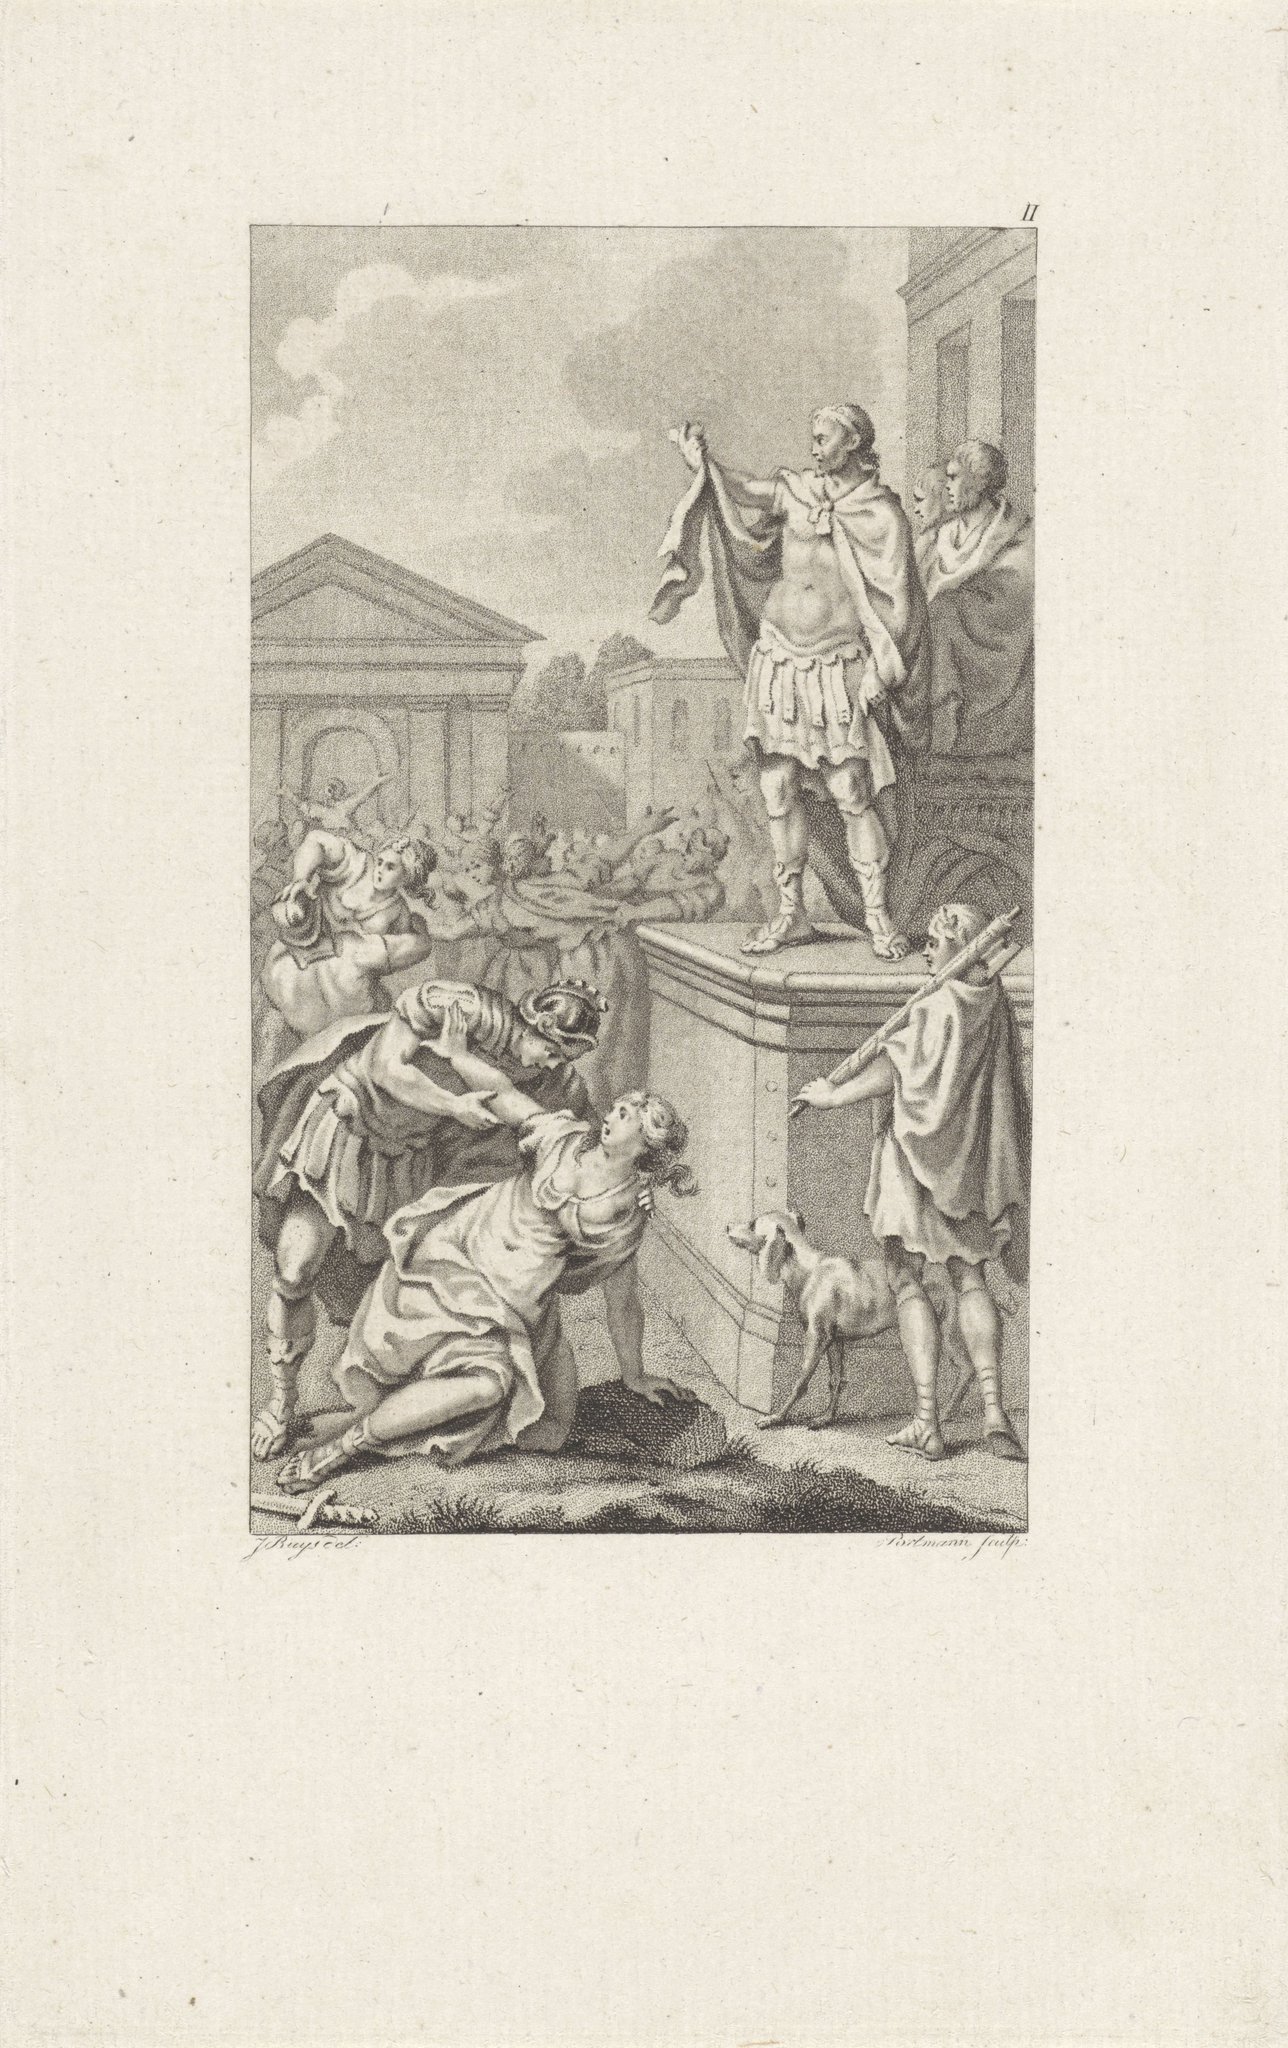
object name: print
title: Sabijnse maagdenroof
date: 1793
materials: paper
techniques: etching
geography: utrecht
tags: rape of the sabine women: they are carried off by romulus and his men during a feast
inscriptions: collector's mark: Lugt 2228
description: Romeinse soldaten grijpen de ongehuwde Sabijnse maagden vast en trachten hen mee te nemen naar Rome. Rechts op een verhoging staat Romulus, die zijn soldaten het teken geeft om de maagden weg te voeren.